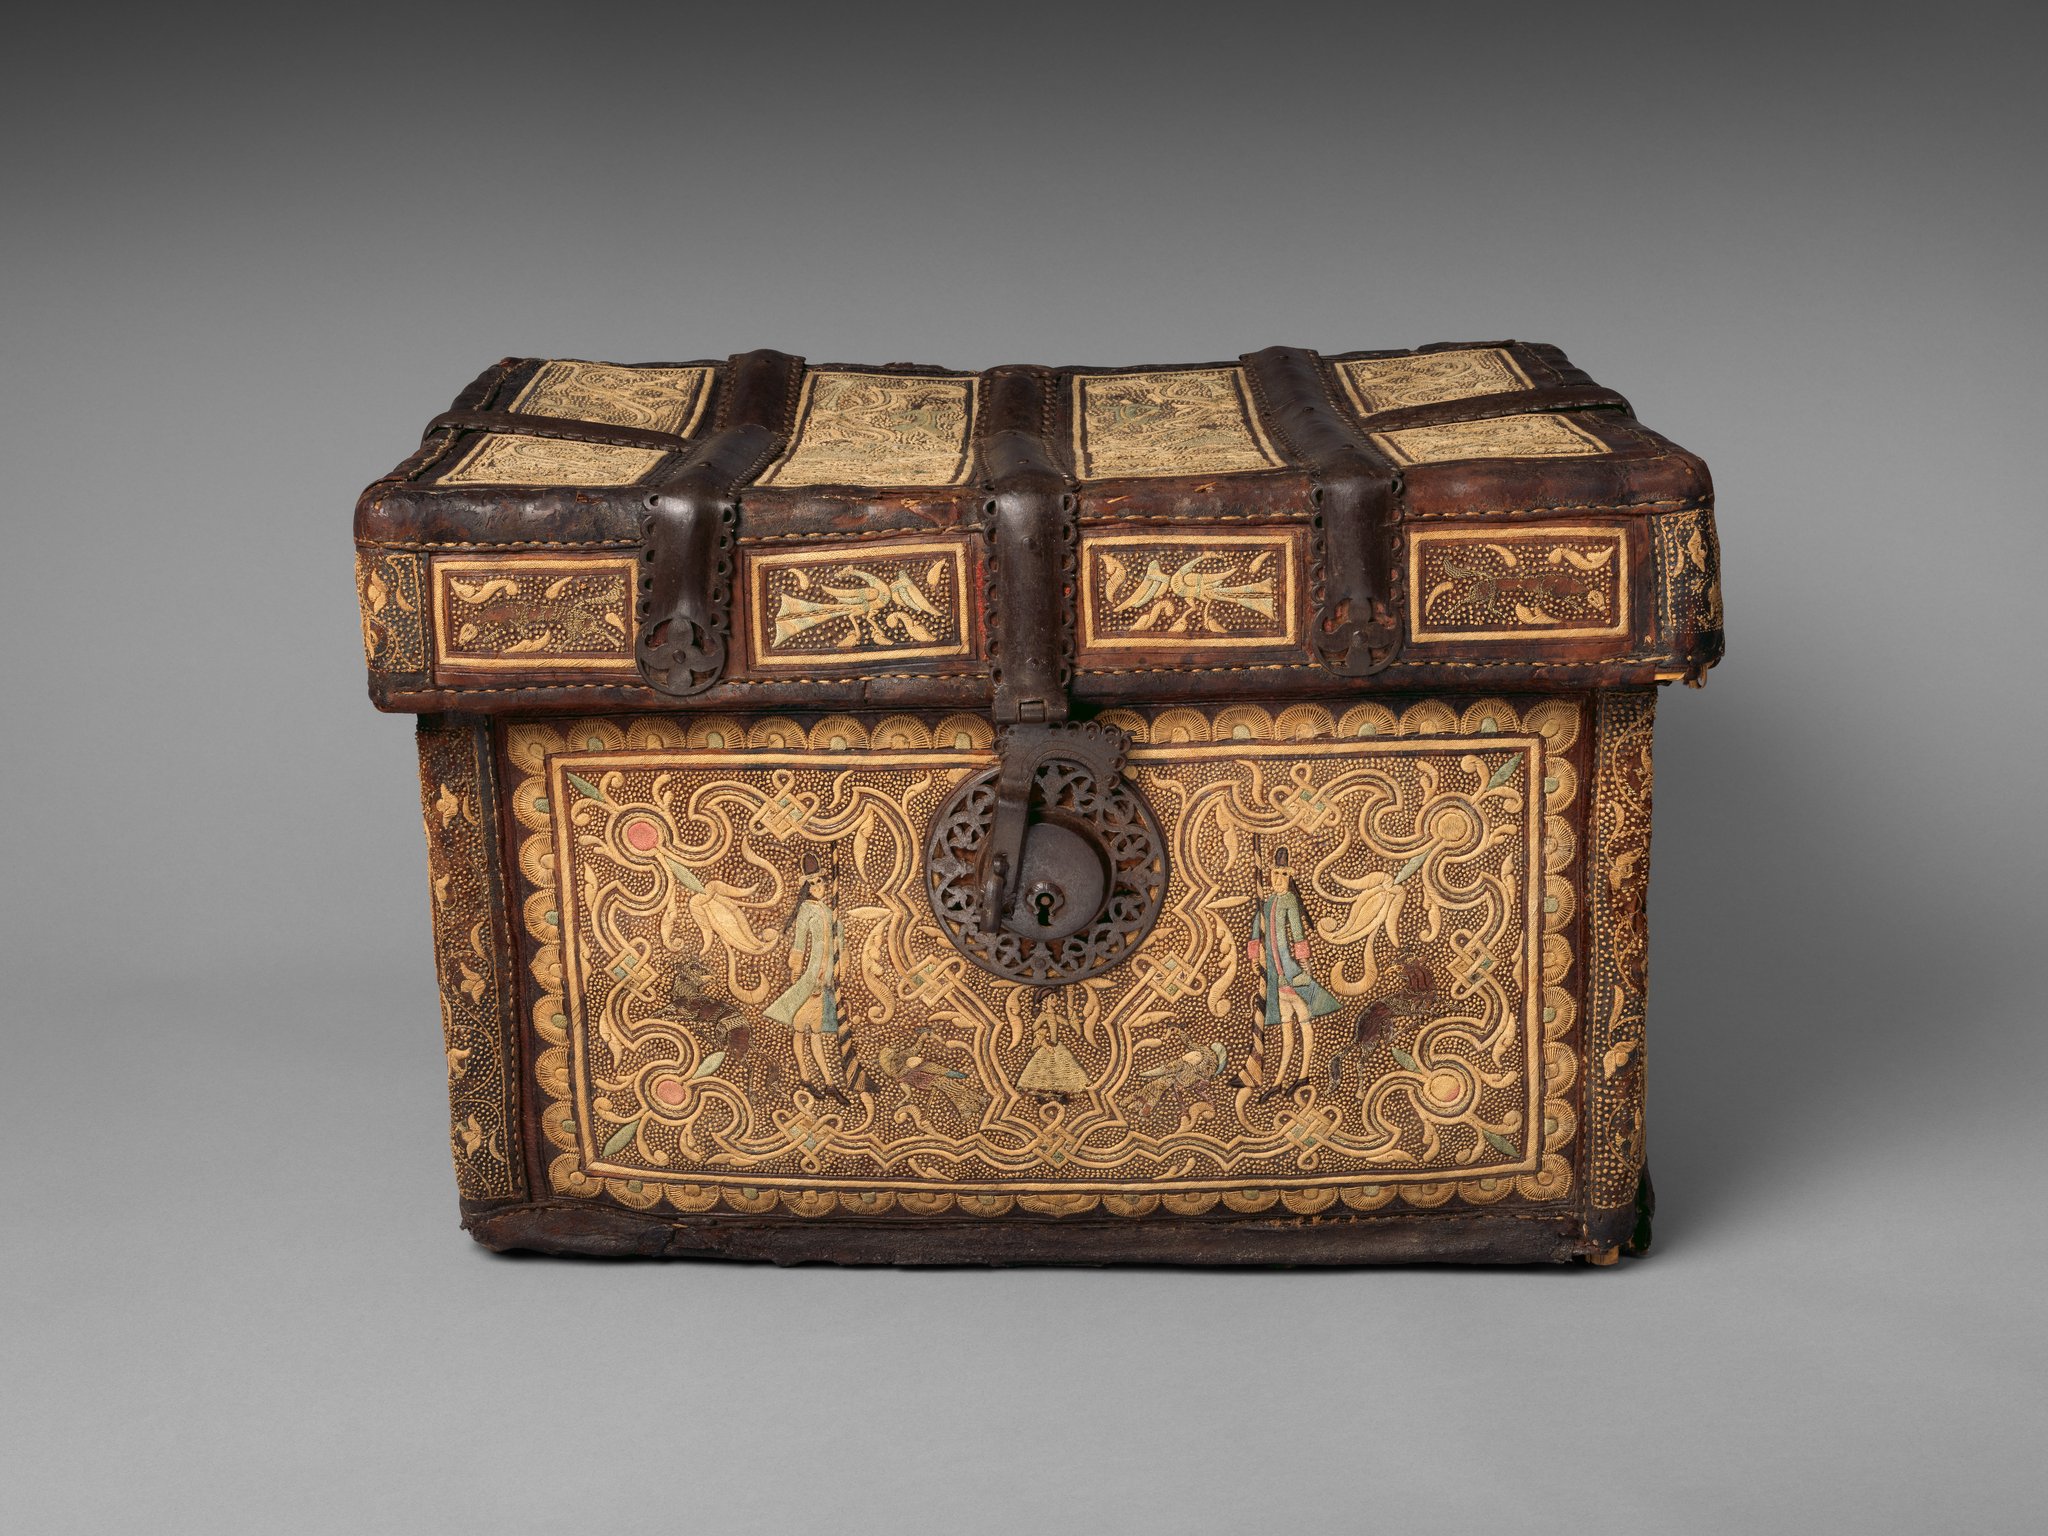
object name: petaca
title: Chest (petaca)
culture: new spain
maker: Anonymous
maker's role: artist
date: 1772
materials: fiber, iron, leather, rattan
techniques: chasing, embroidery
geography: mexico